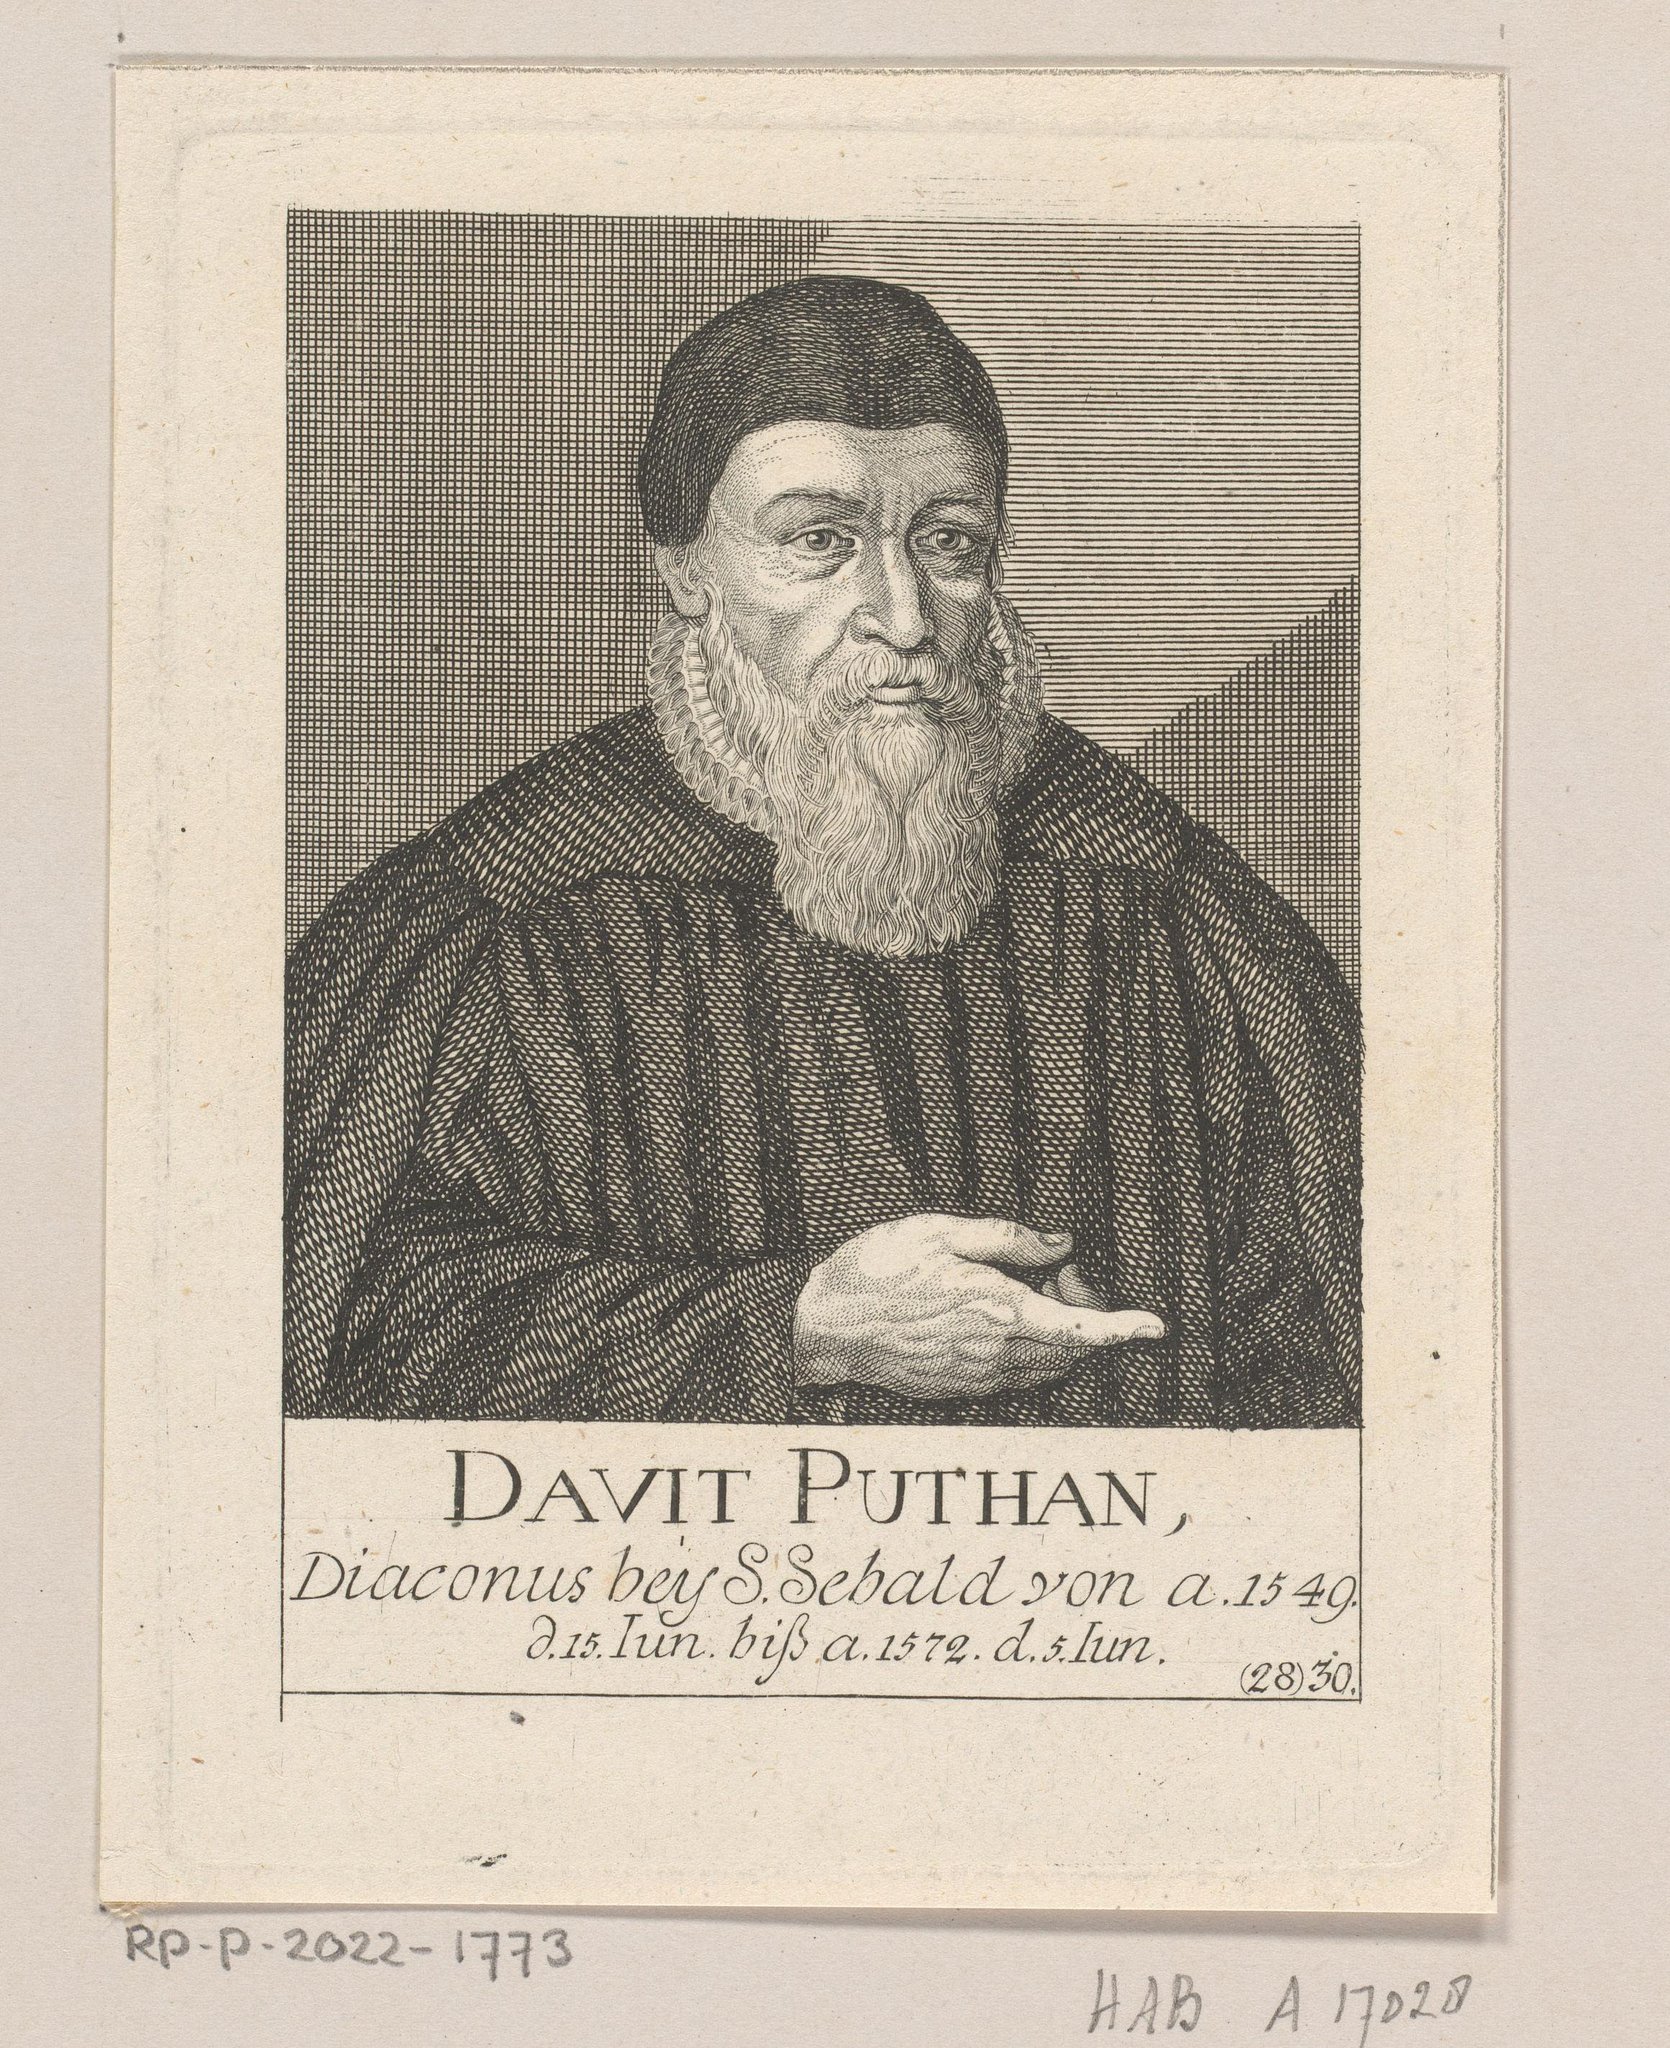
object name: print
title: Portret van David Puthan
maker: christoph melchior roth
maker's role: print maker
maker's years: 1720-1798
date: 1756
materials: paper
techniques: engraving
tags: theologian, historical persons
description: Prent waarschijnlijk uit: Würfel, Andreas. Diptycha ecclesiae Sebaldianae (...). Neurenberg: Christoph Melchior Roth, 1756.